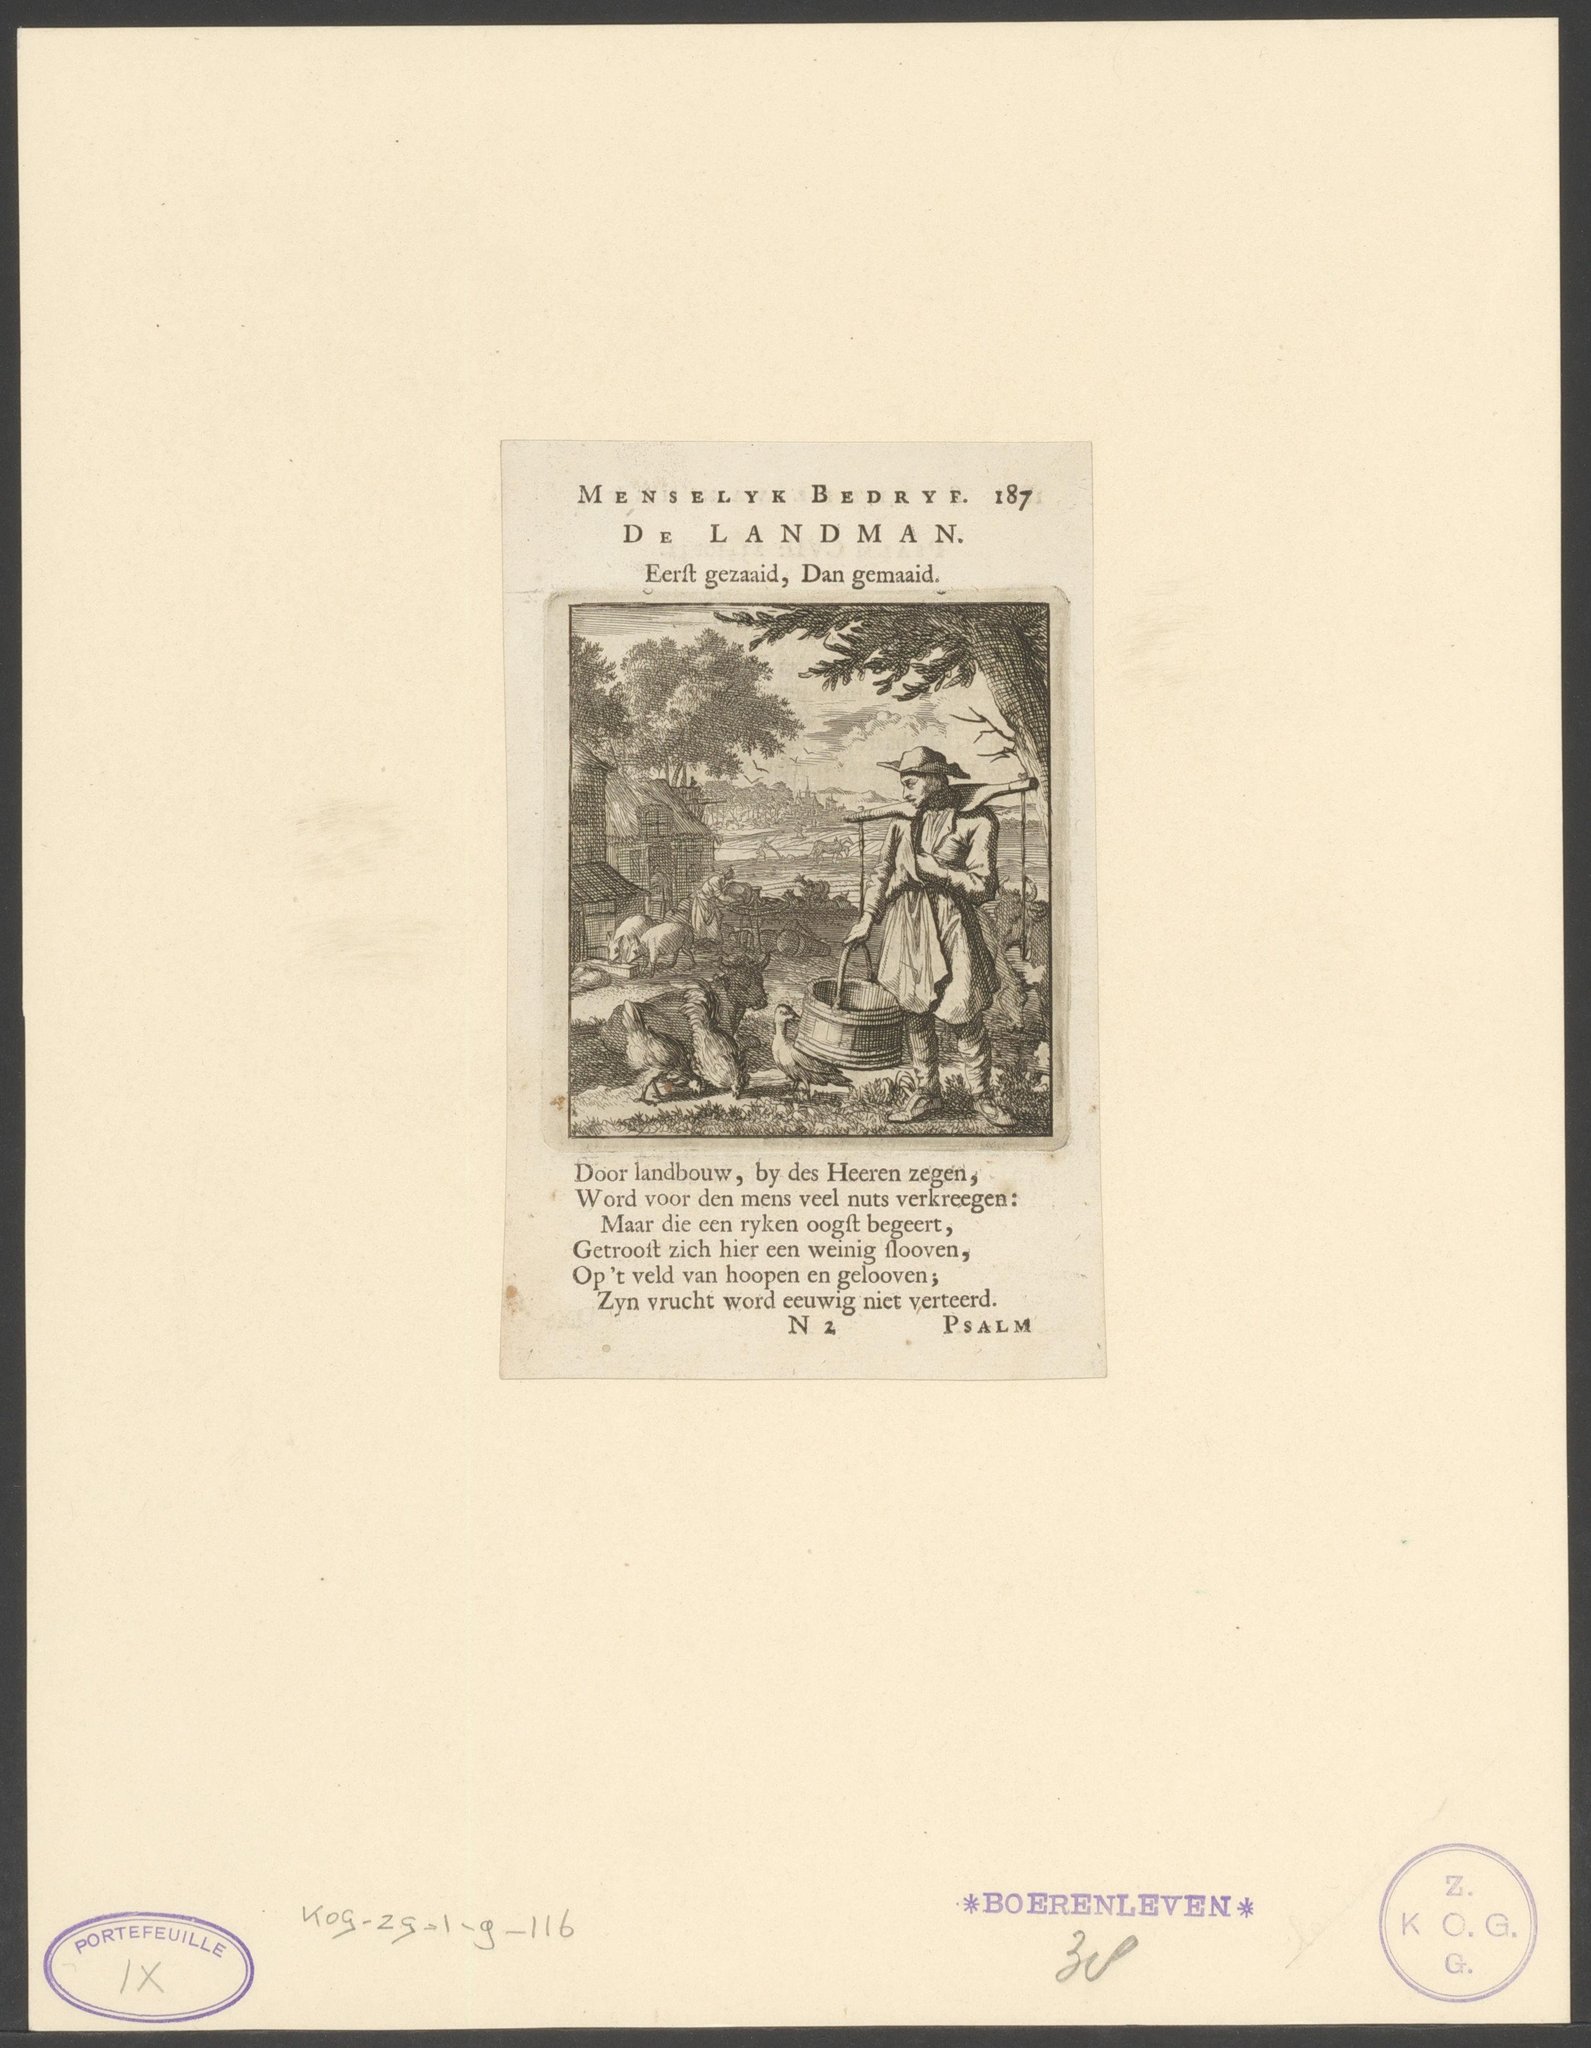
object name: print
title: De landman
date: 1718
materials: paper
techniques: etching, letterpress printing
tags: farmers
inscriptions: collector's mark: Lugt 1641, stamp, stamp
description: Prent voor het eerst verschenen in de 100-delige serie beroepsprenten van Jan en Caspar Luyken, getiteld: Het menselyk bedryf. S.l.s.n., 1694 (eerste druk). Huidige staat uit: Luyken, Jan en Caspar. Spiegel van het menselyk bedryf (...). Amsterdam: Cornelis van der Sys, 1718, p. 187.